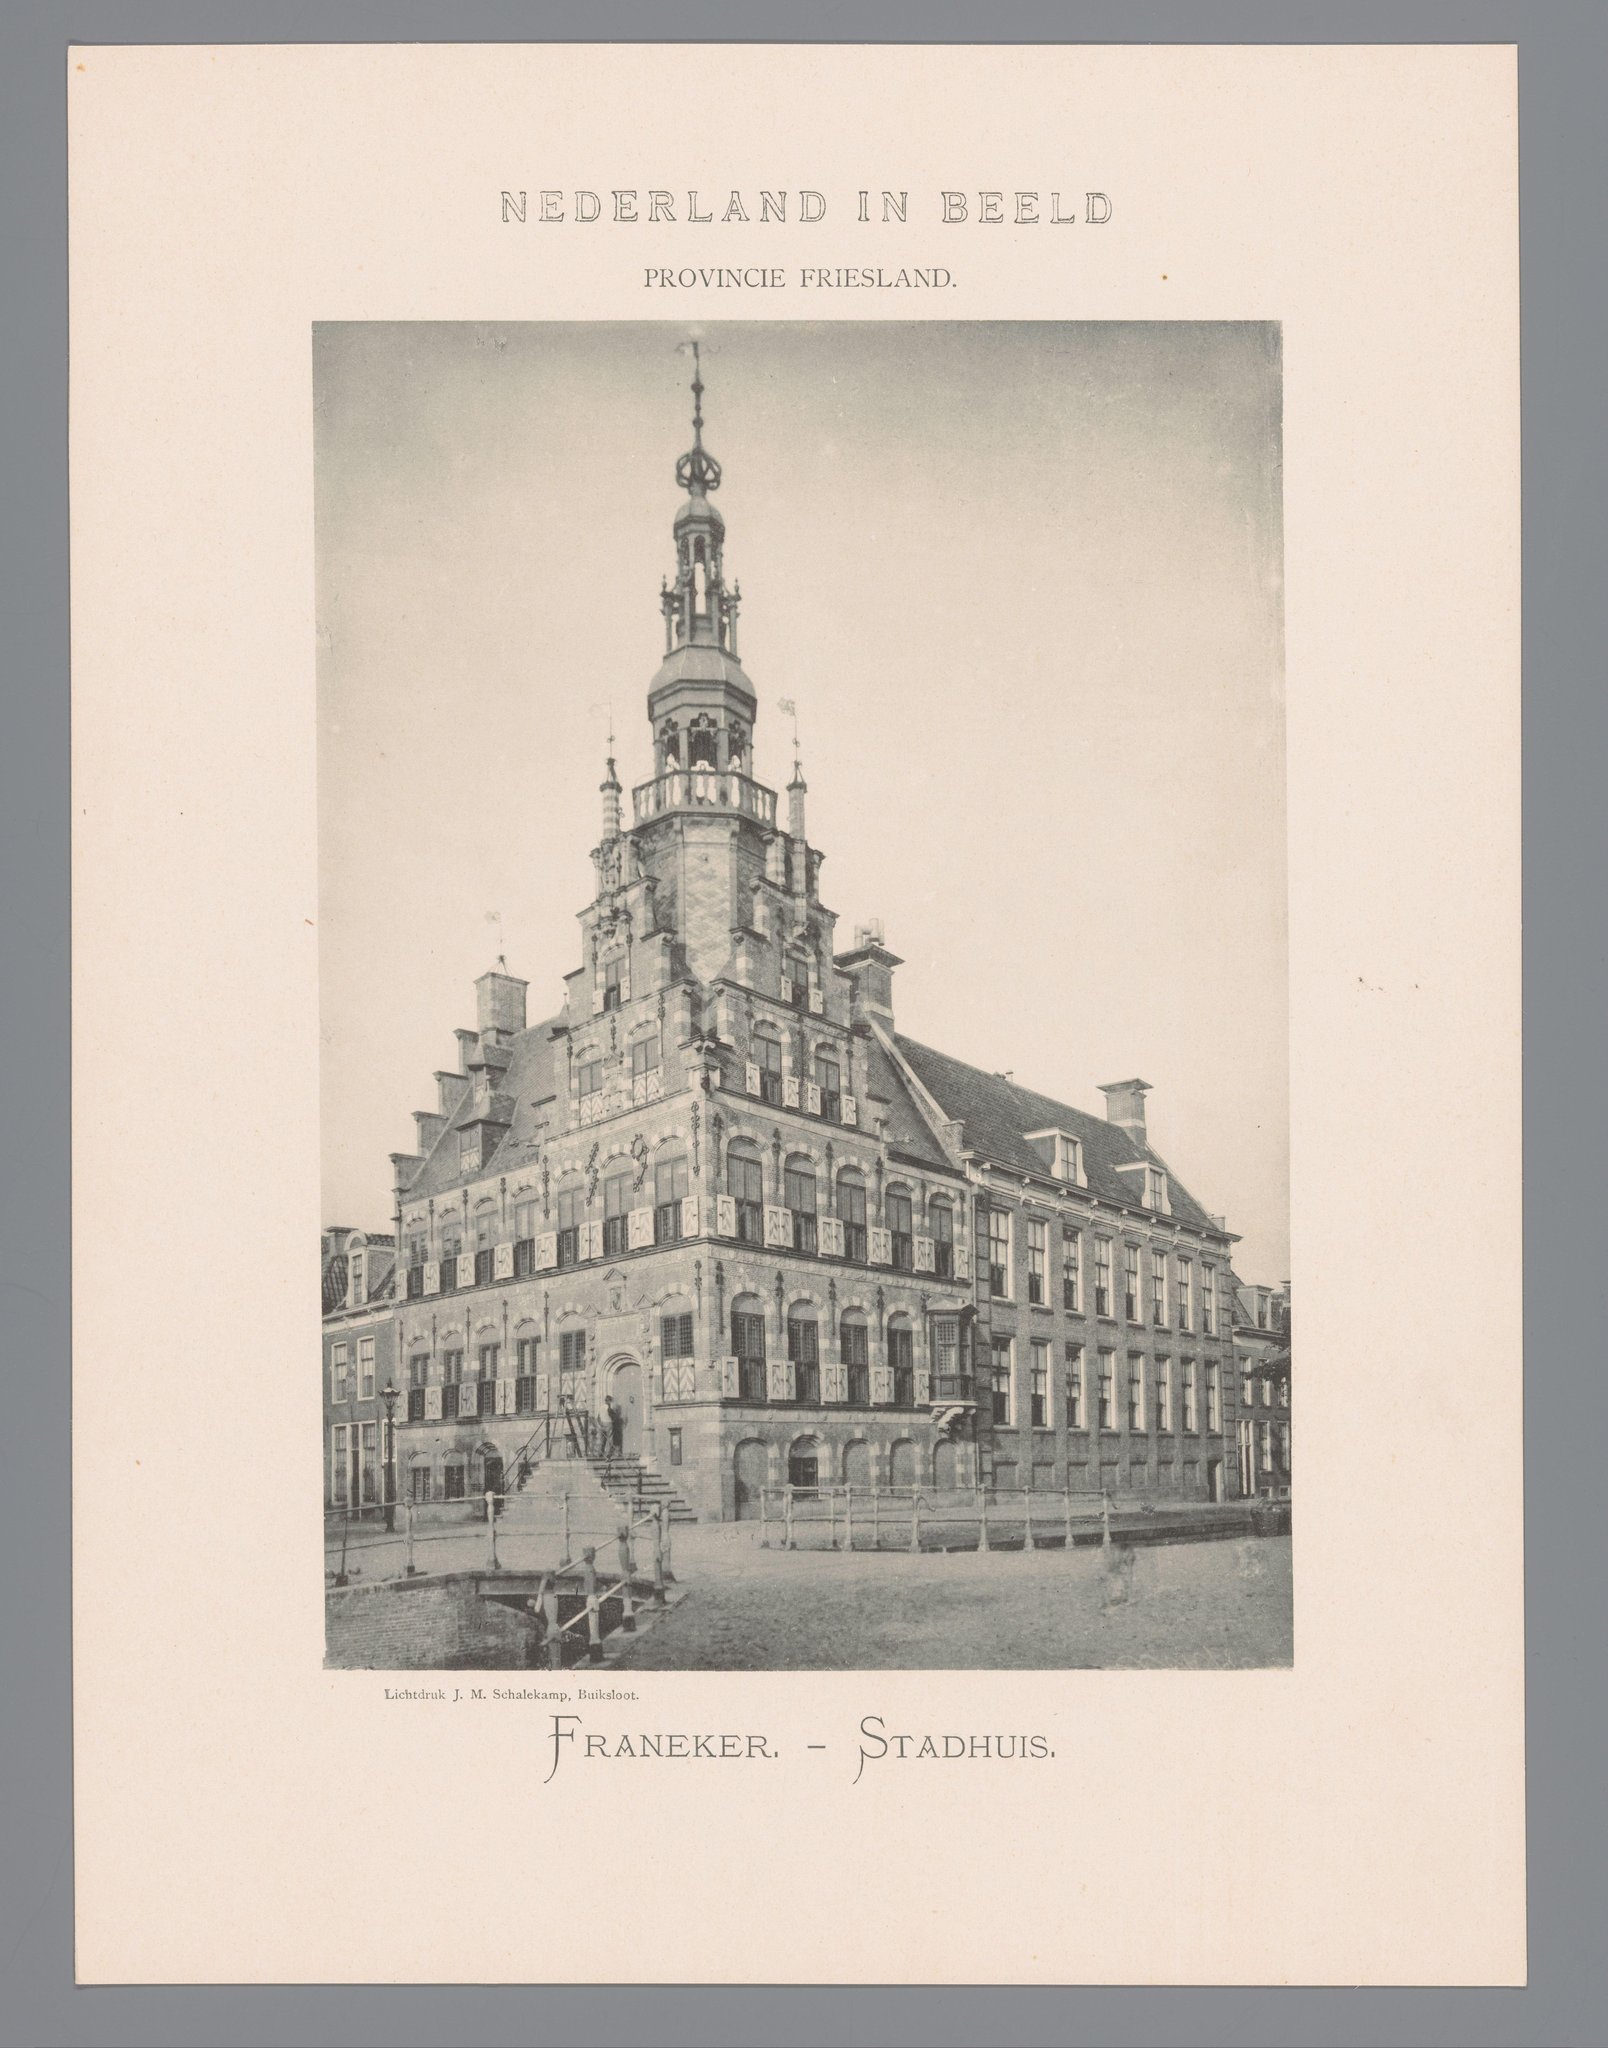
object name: photomechanical print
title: Franeker-Stadhuis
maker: johan marinus schalekamp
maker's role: publisher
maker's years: 1844-1912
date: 1896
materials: paper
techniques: photograph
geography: buiksloot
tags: townhall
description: Afdruk uit: Nederland in Beeld. Buiksloot: J.M. Schalekamp, 1896.